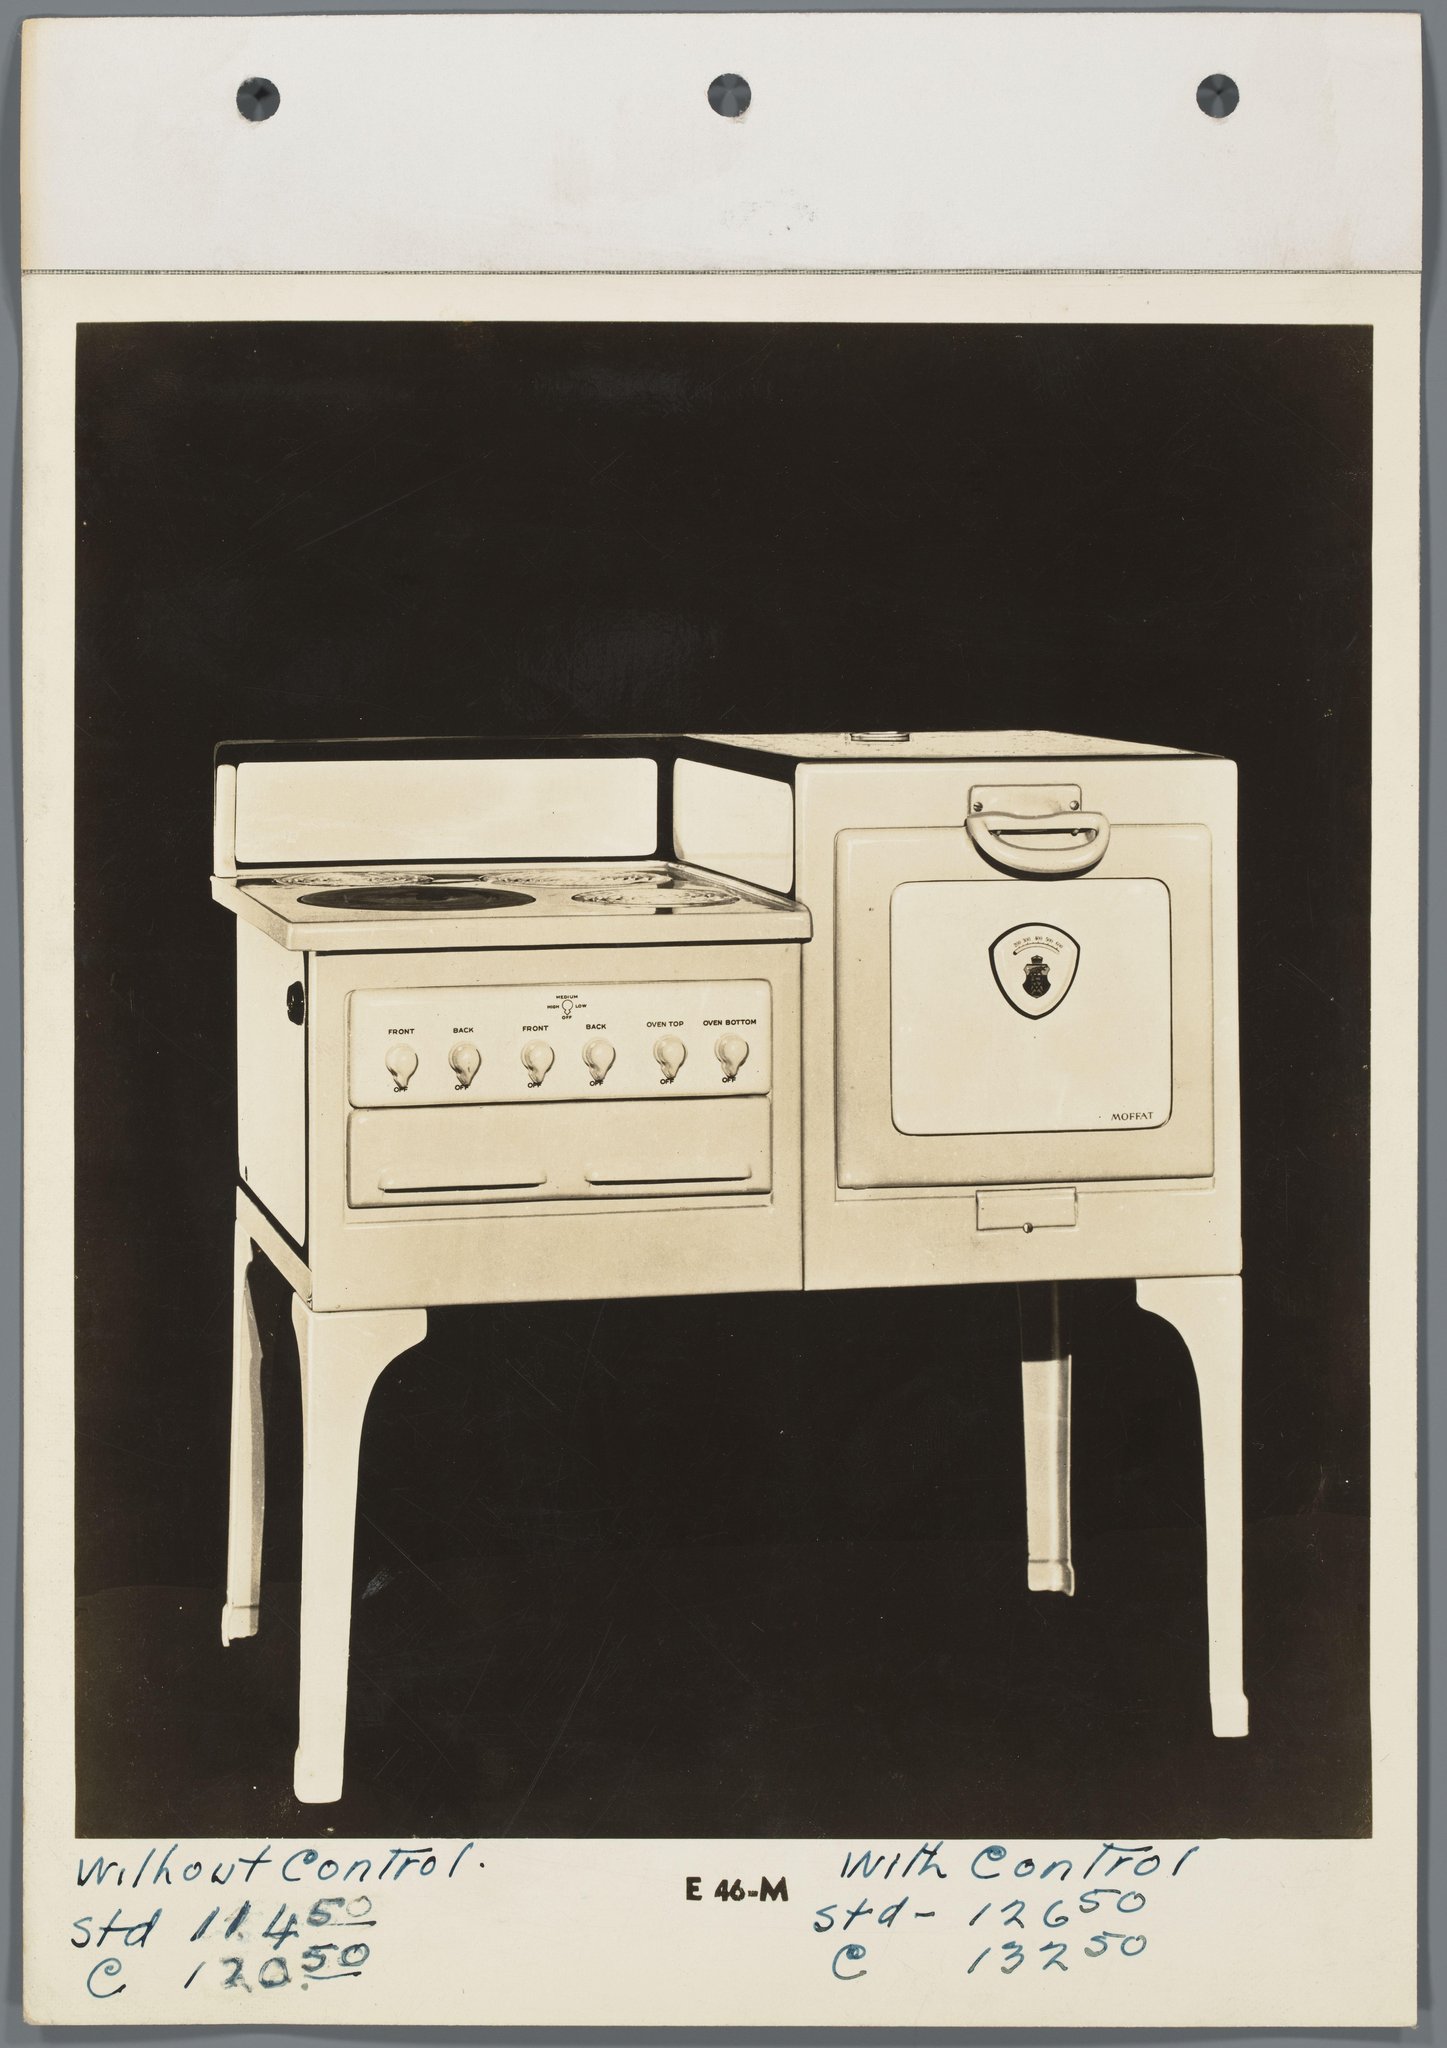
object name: photograph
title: Foto van Moffat ovens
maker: Anonymous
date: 1935-1940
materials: paper, photographic support, textile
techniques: gelatin silver print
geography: canada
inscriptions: inscription: ‘With control std - 12650 C 13250’, inscription: ‘E 46-M’, inscription: ‘Without control. std 11450. C 12050’